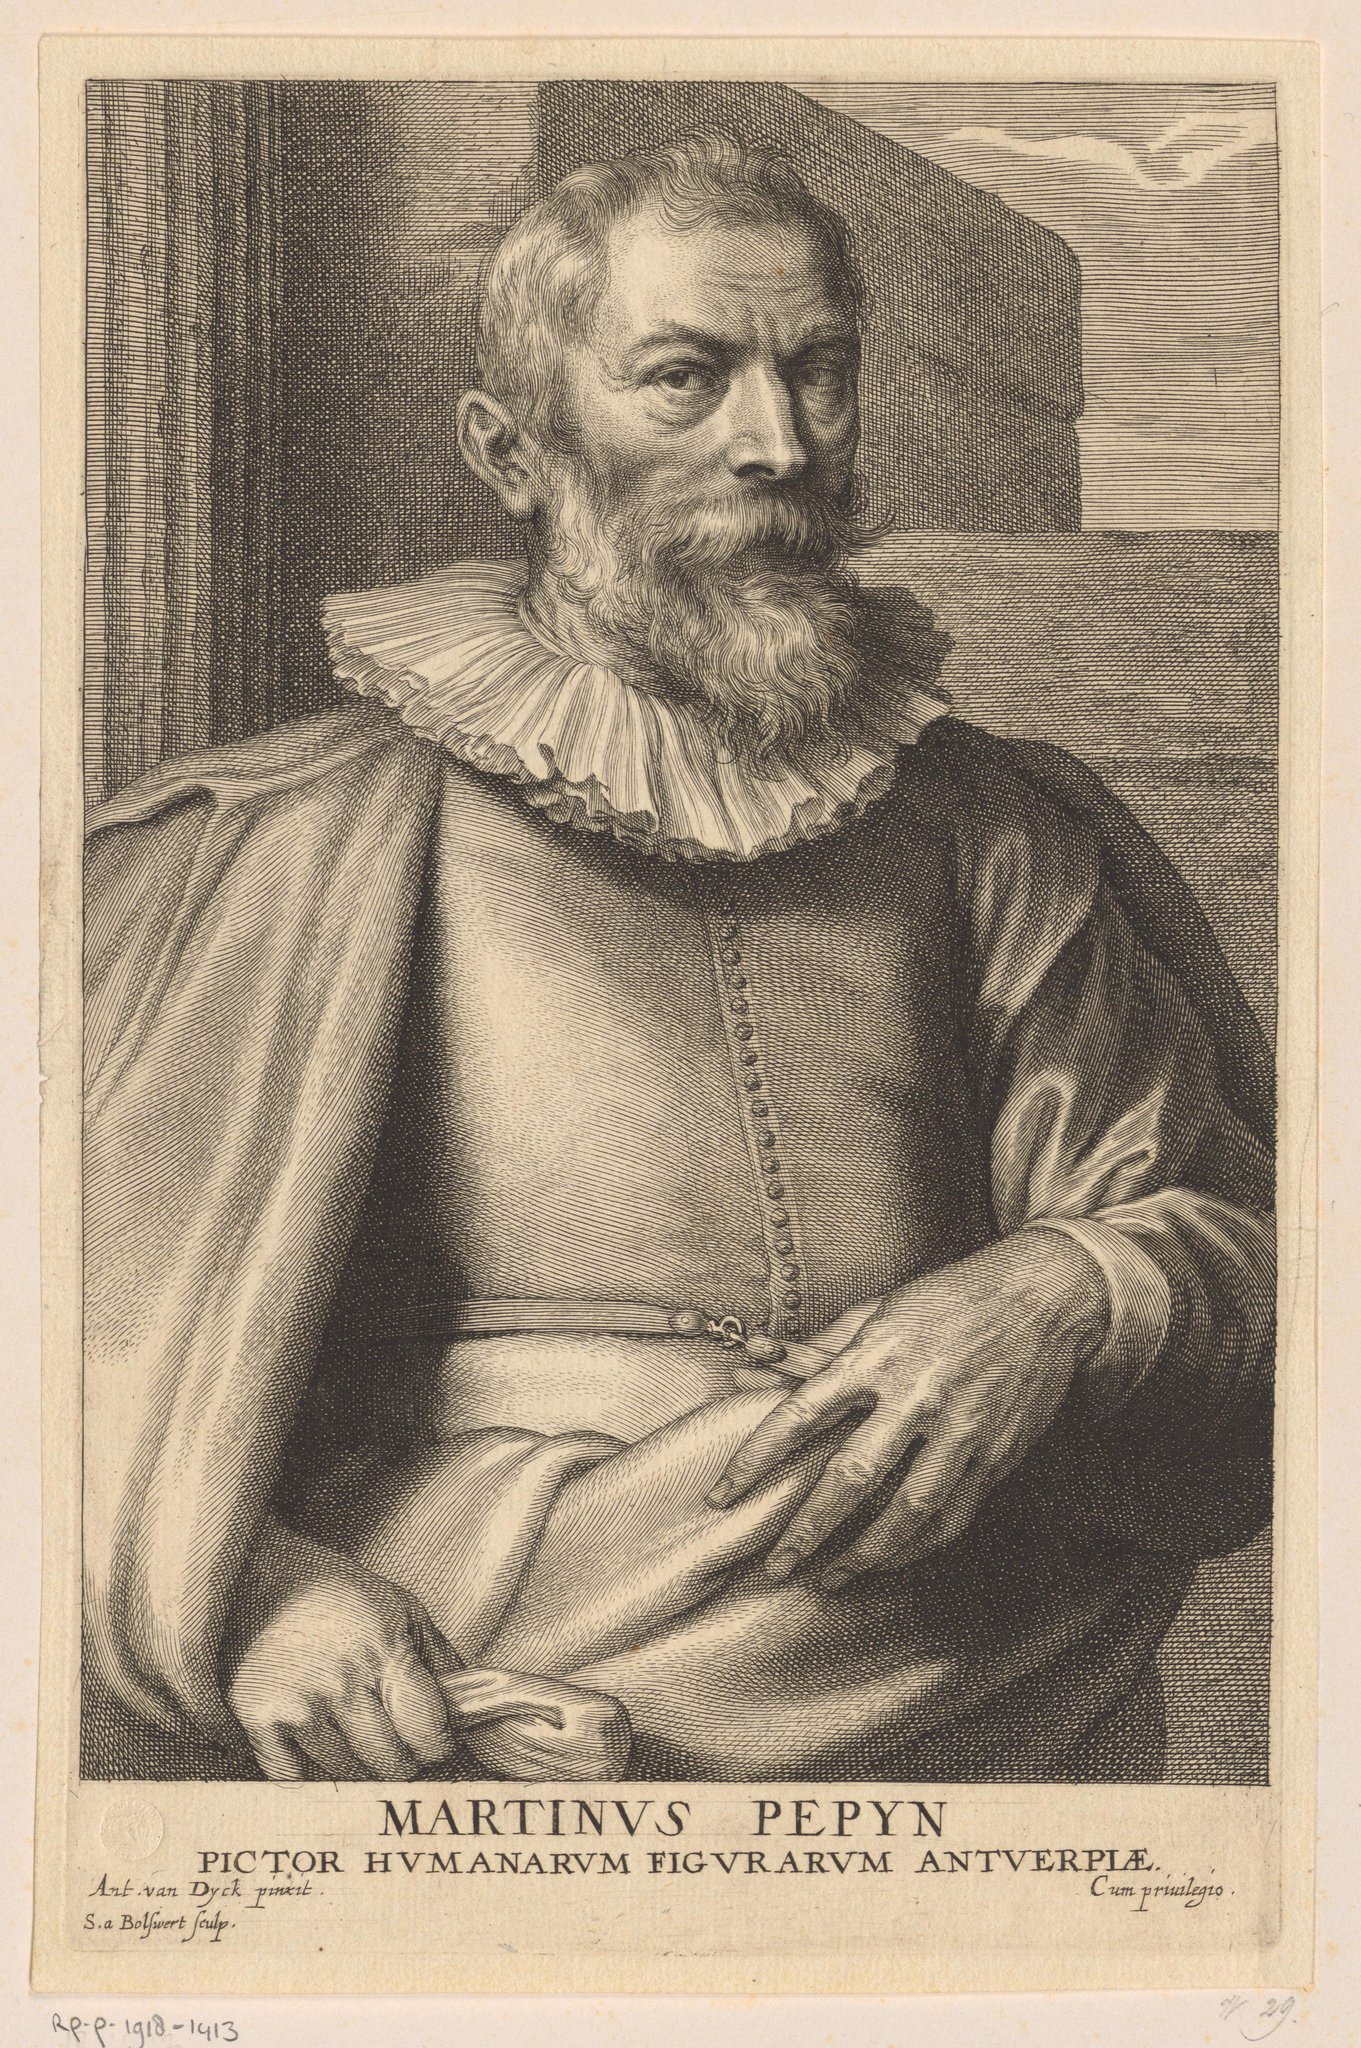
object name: print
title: Portret van Marten Pepijn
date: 1596-1659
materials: paper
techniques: engraving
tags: artist, adult man, historical persons, portrait, self-portrait of painter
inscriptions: collector's mark: Lugt 2233, check stamp: Lugt 2581, collector's mark: Lugt 1377